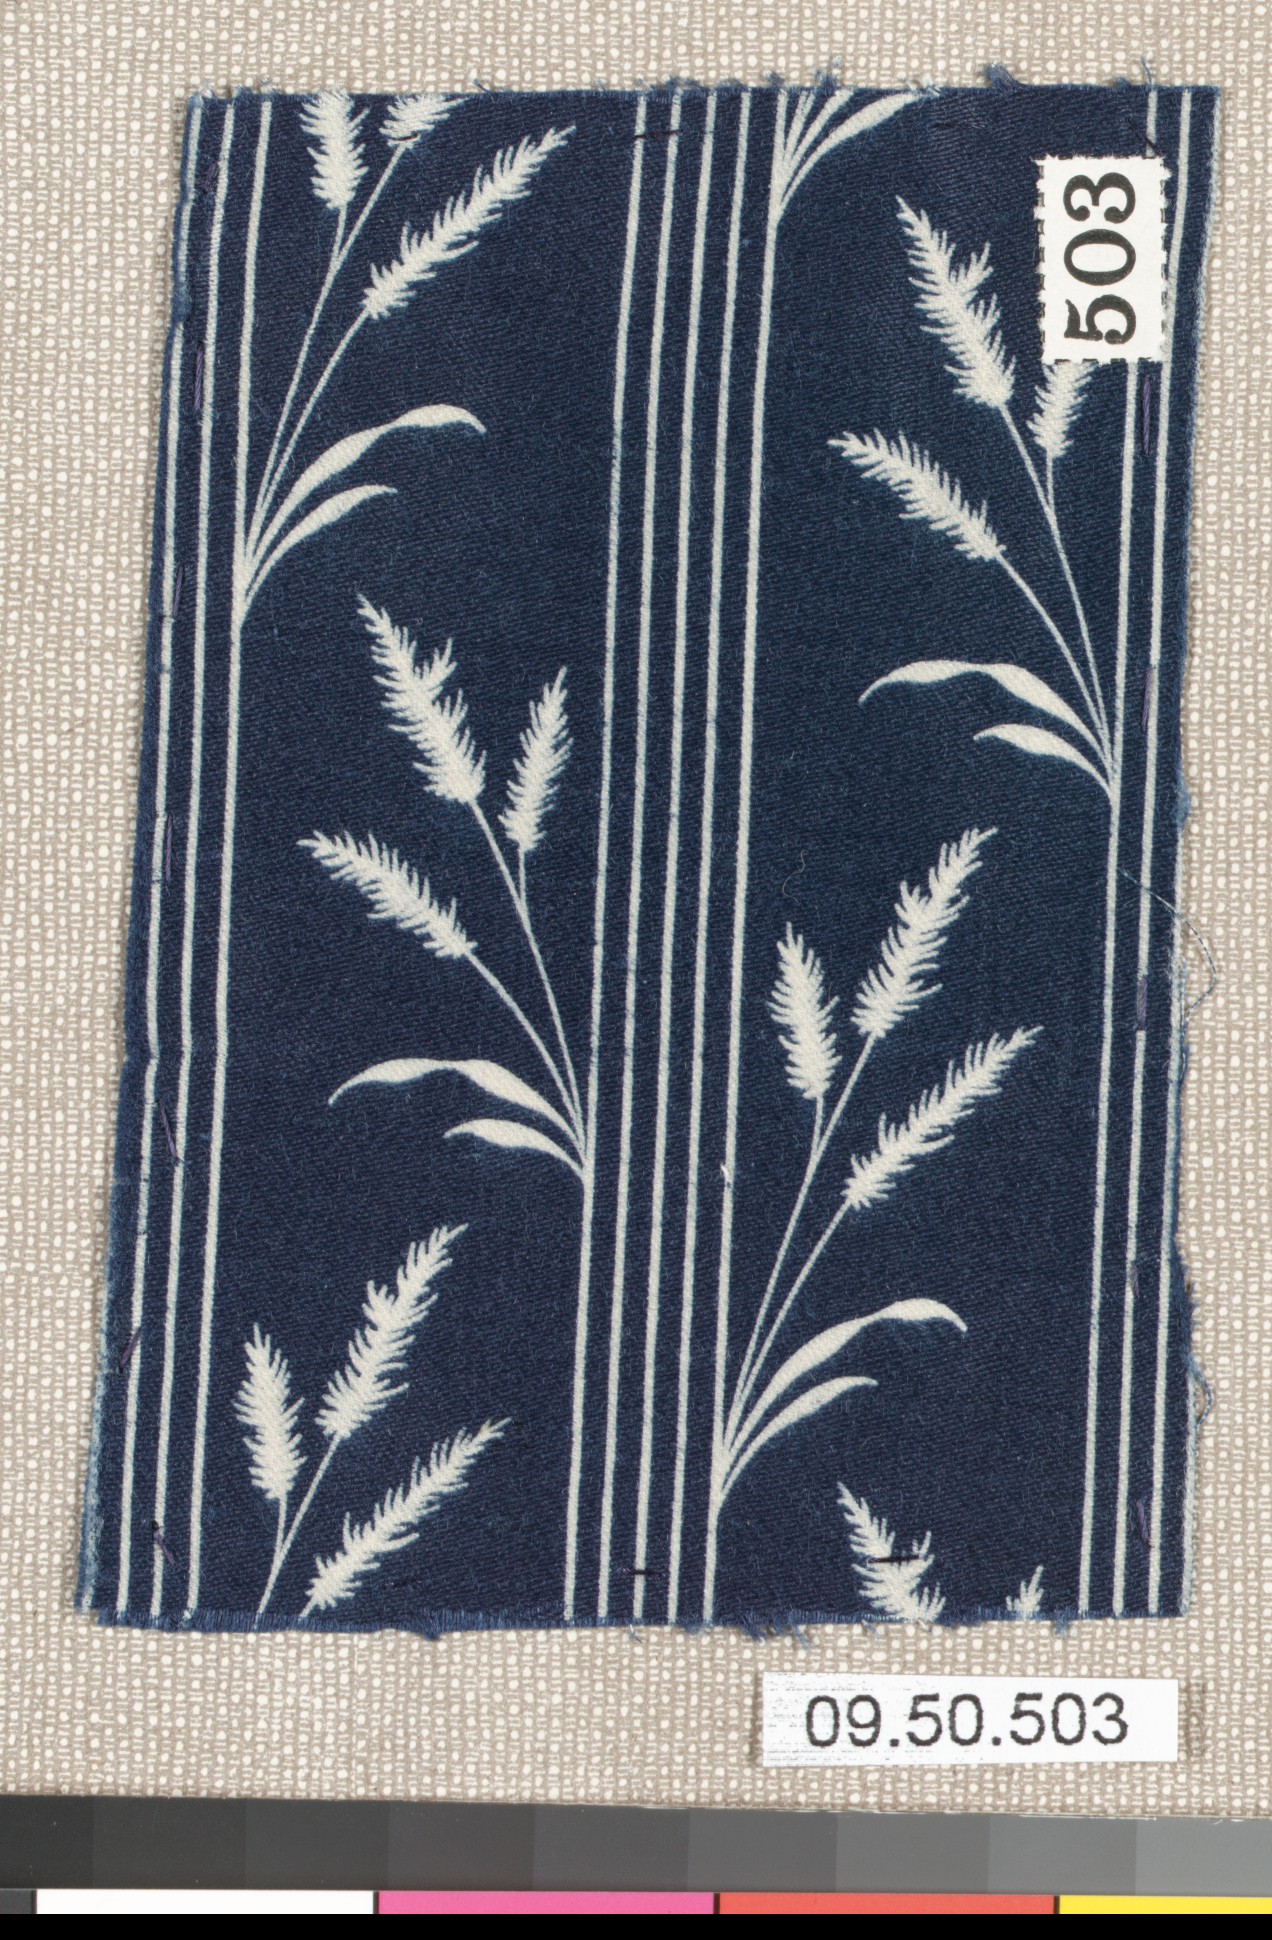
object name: piece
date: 1801-1900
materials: cotton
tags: leaves